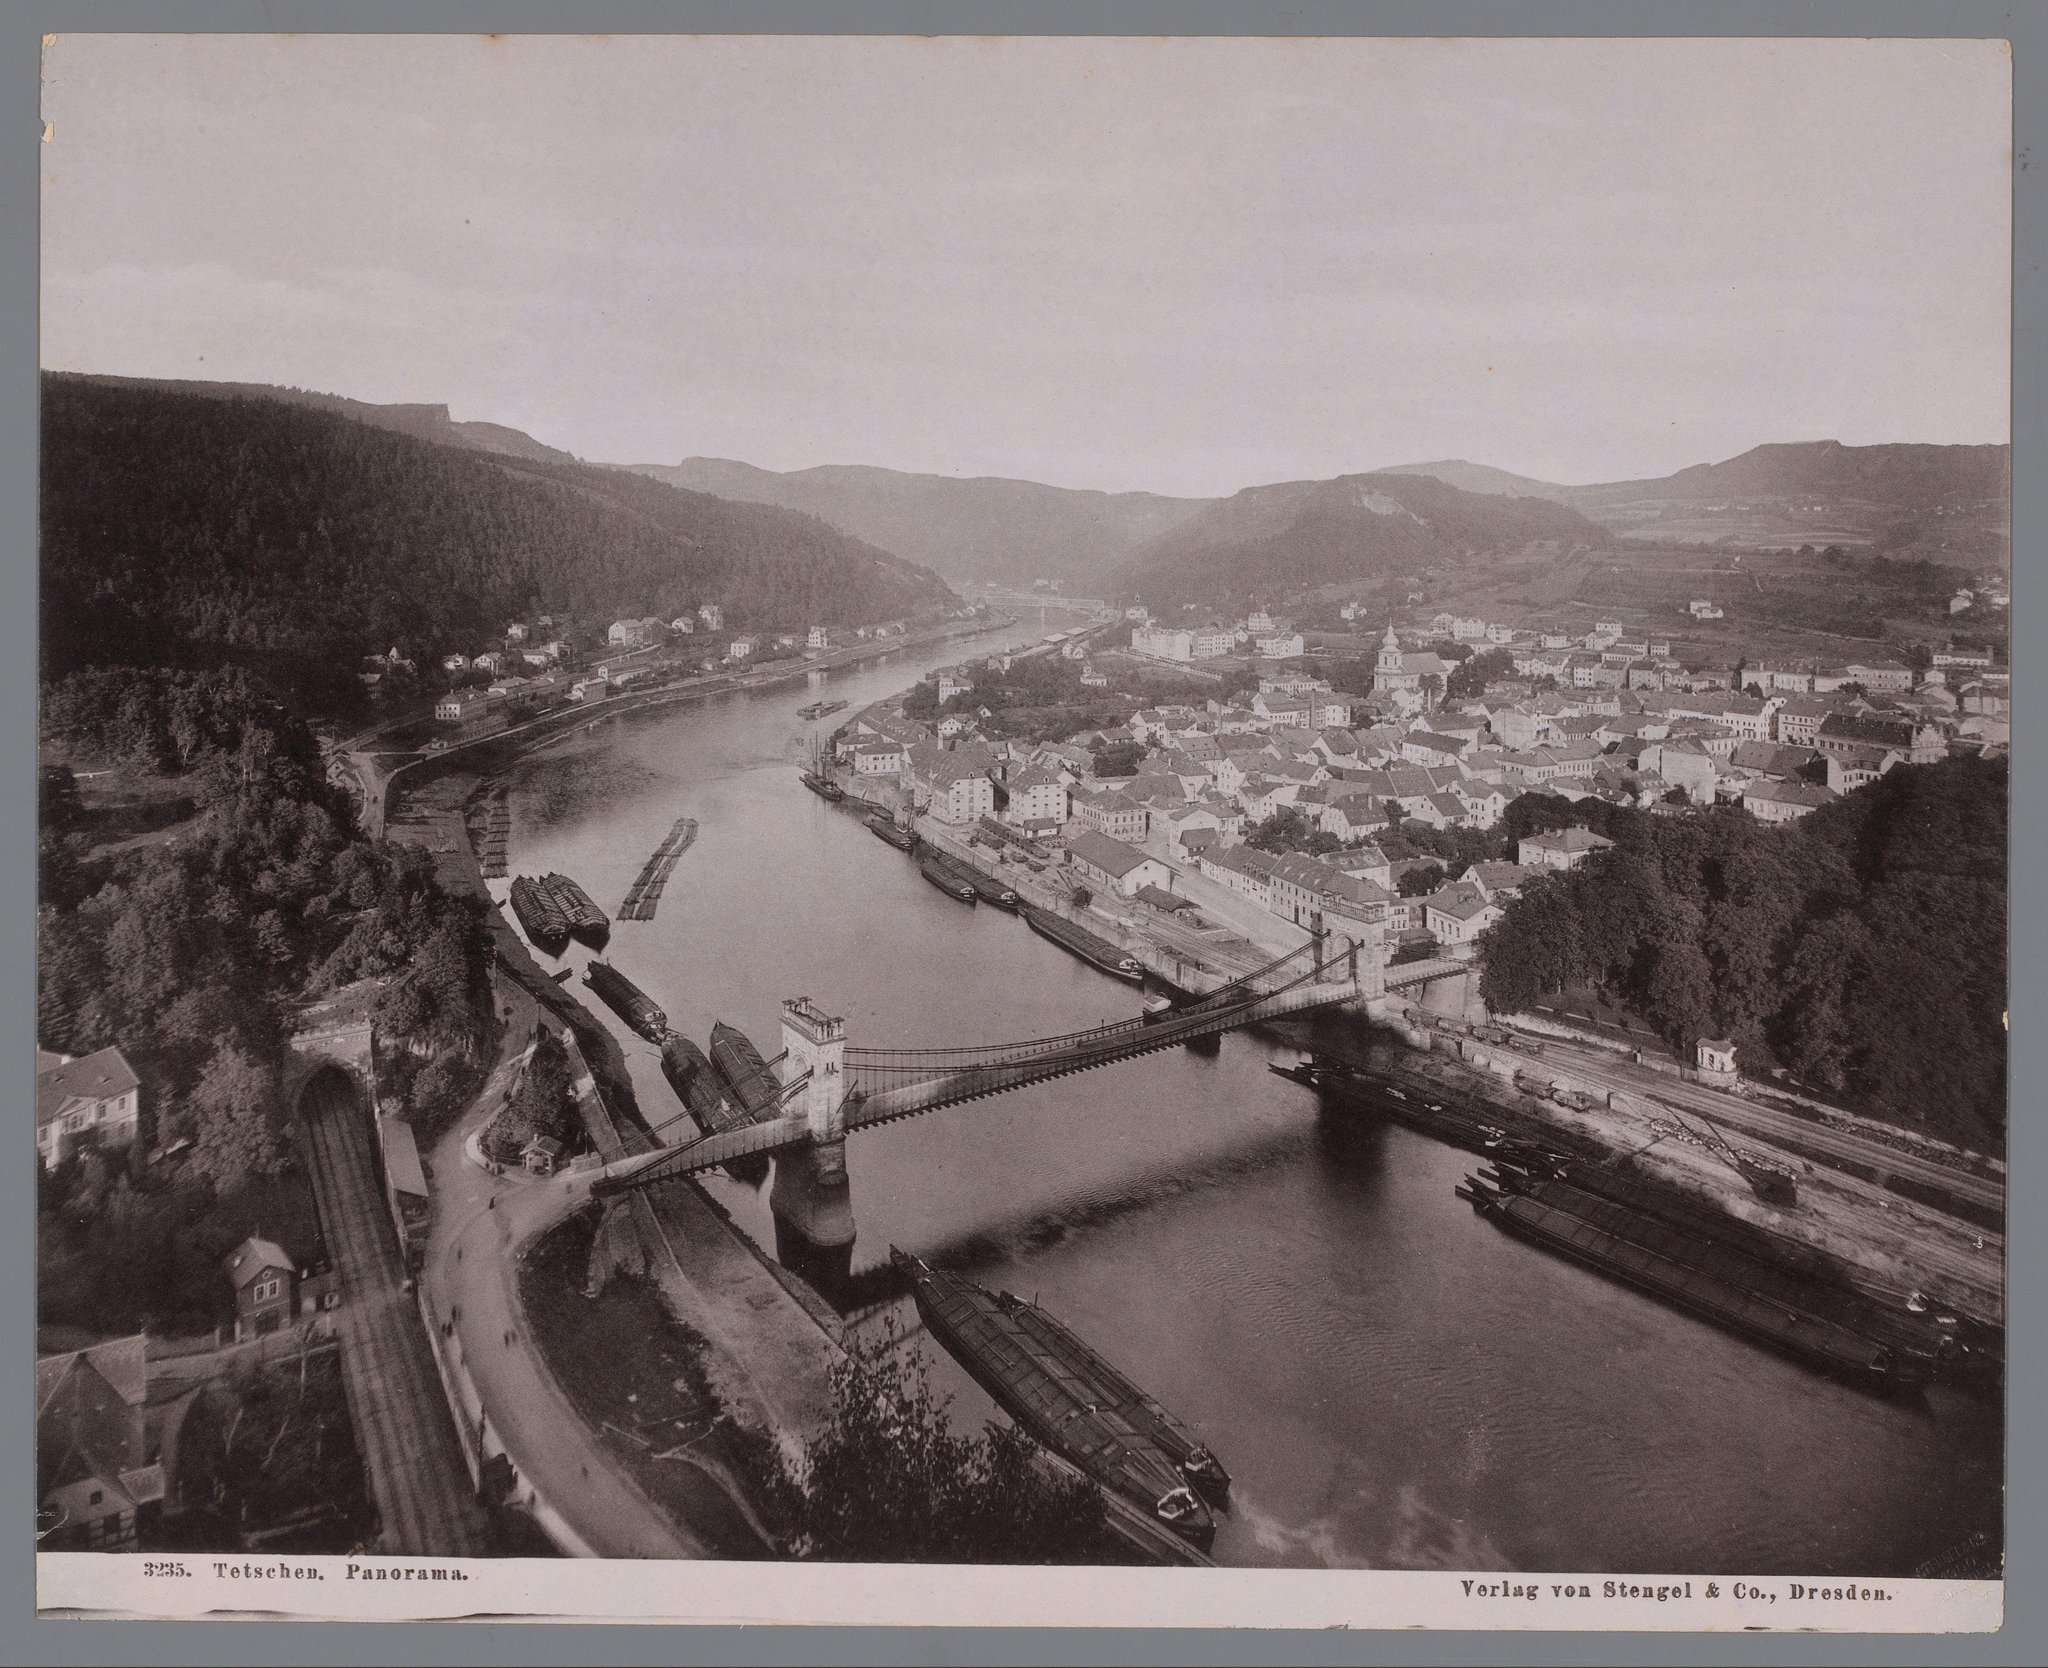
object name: photograph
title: Panorama van de stad Decín (Duits: Tetschen-Bodenbach) aan de Elbe, Tsjechië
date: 1890-1925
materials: paper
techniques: photoaquatint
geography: germany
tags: tetschen, elbe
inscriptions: inscription: ‘Verlag von Stengel & Co., Dresden.’, inscription: ‘3235. Tetschen, Panorama.’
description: Panorama van de stad Decín (Duits: Tetschen-Bodenbach) aan de Elbe in Tsjechië. Vanaf een zeer hoog standpunt genomen waardoor de stroom van de rivier en de ligging van de stad centraal staan.